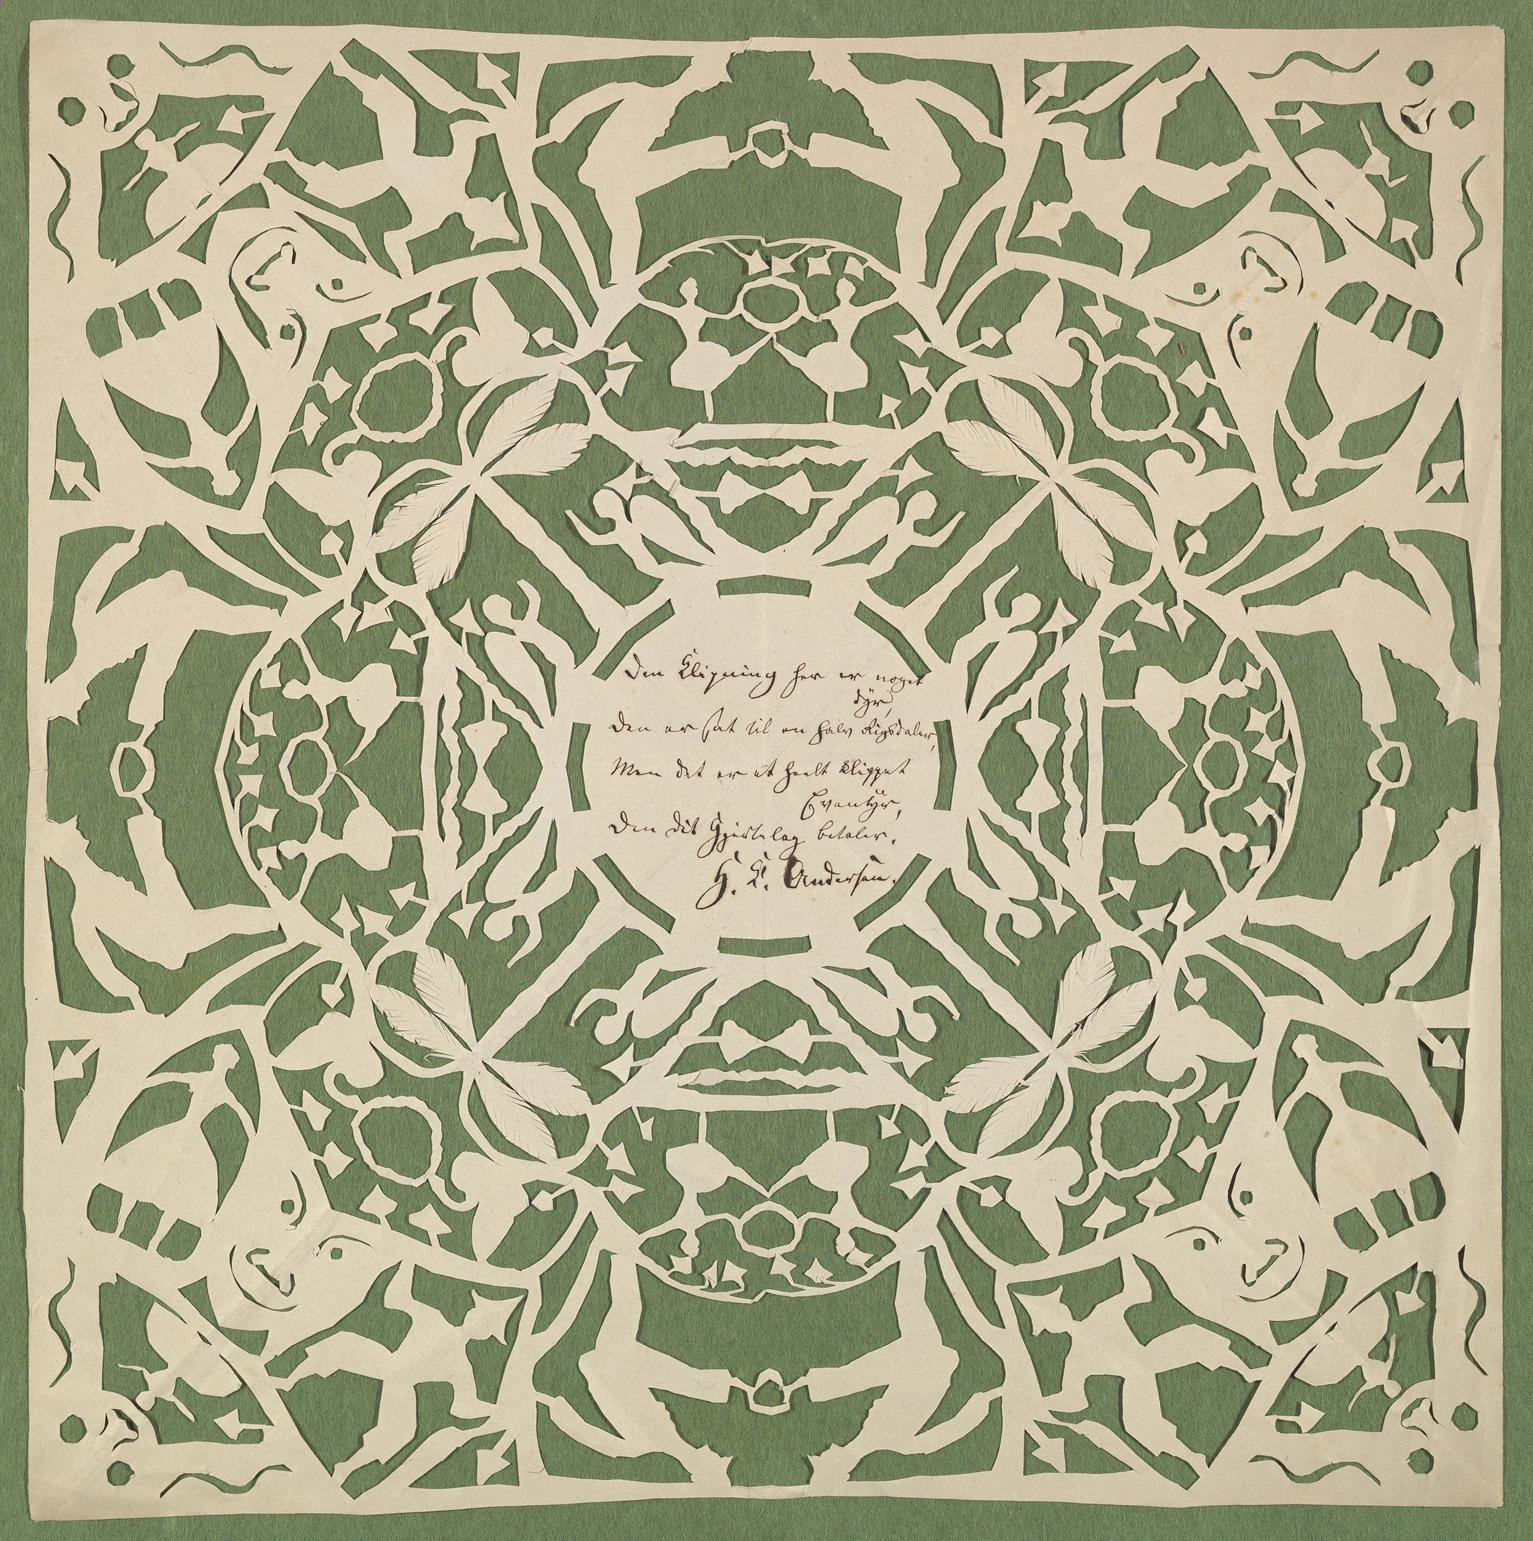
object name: cut paper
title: A Fully Cut Fairy Tale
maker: hans christian andersen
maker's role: artist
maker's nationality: danish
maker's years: 1805-1875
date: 1864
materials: paper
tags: faces,men,women